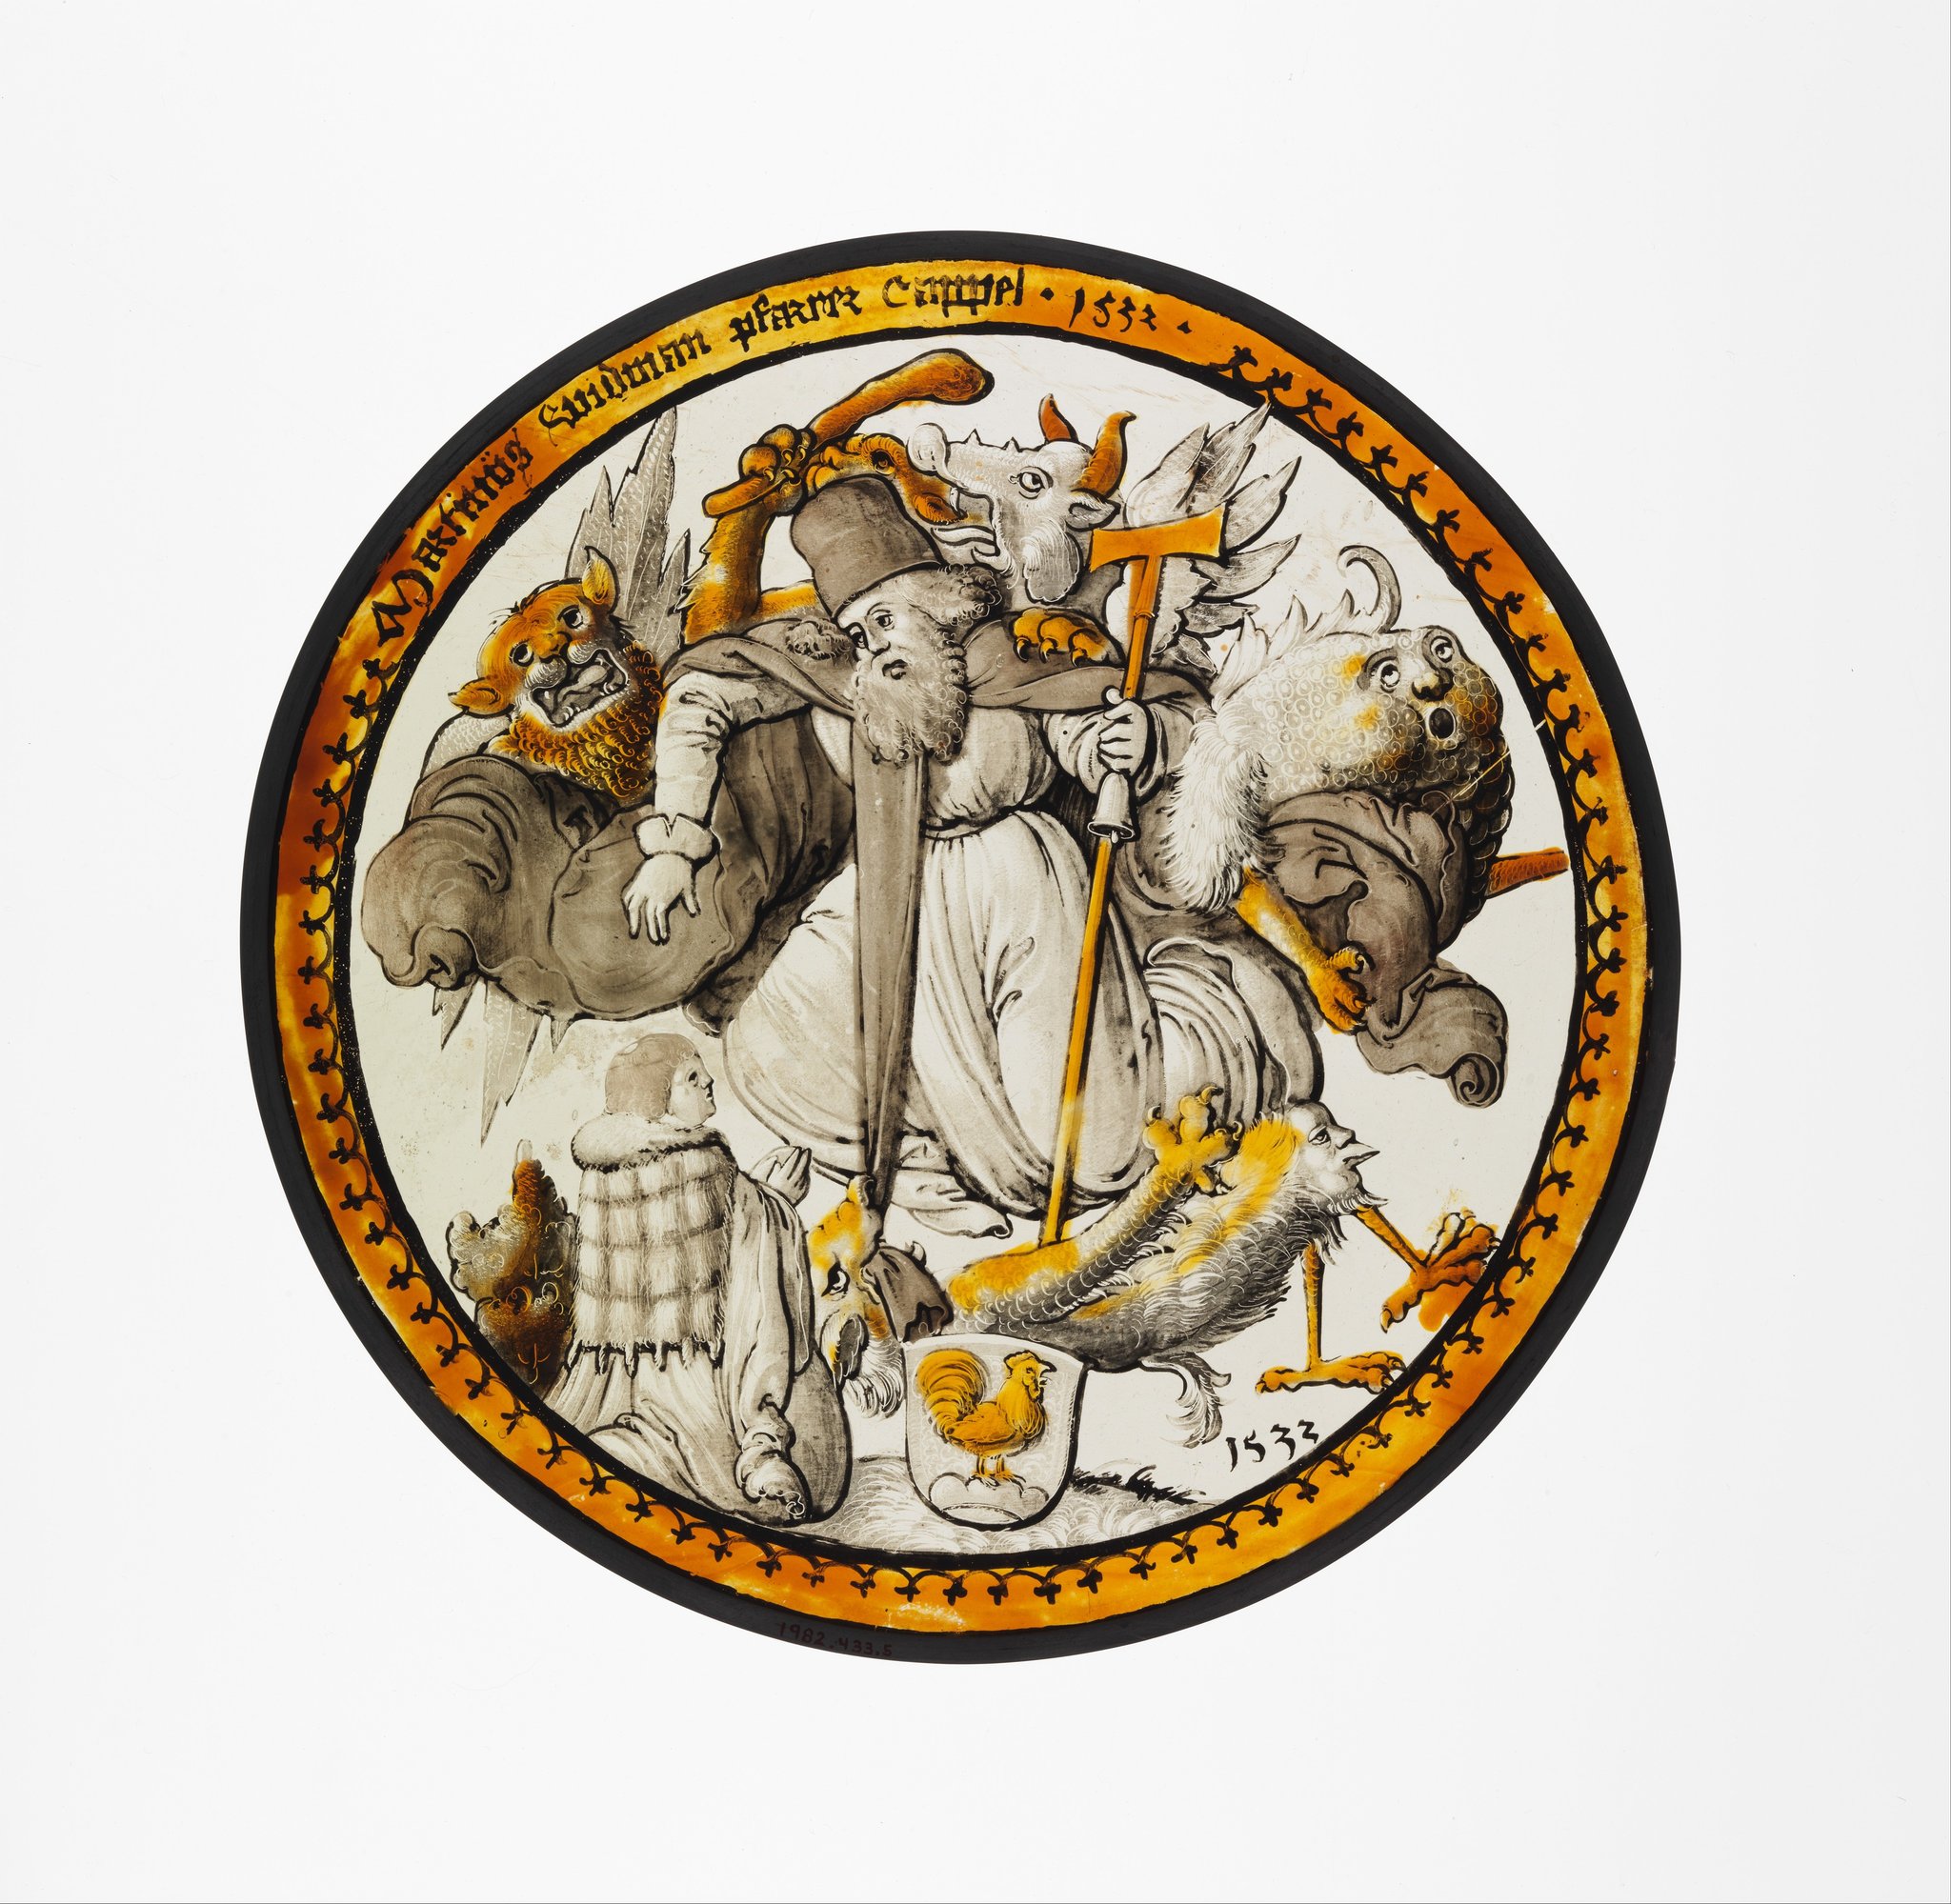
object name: roundel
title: Roundel with the Temptation of Saint Anthony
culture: german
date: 1532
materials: glass, paint, pigment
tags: demons,coat of arms